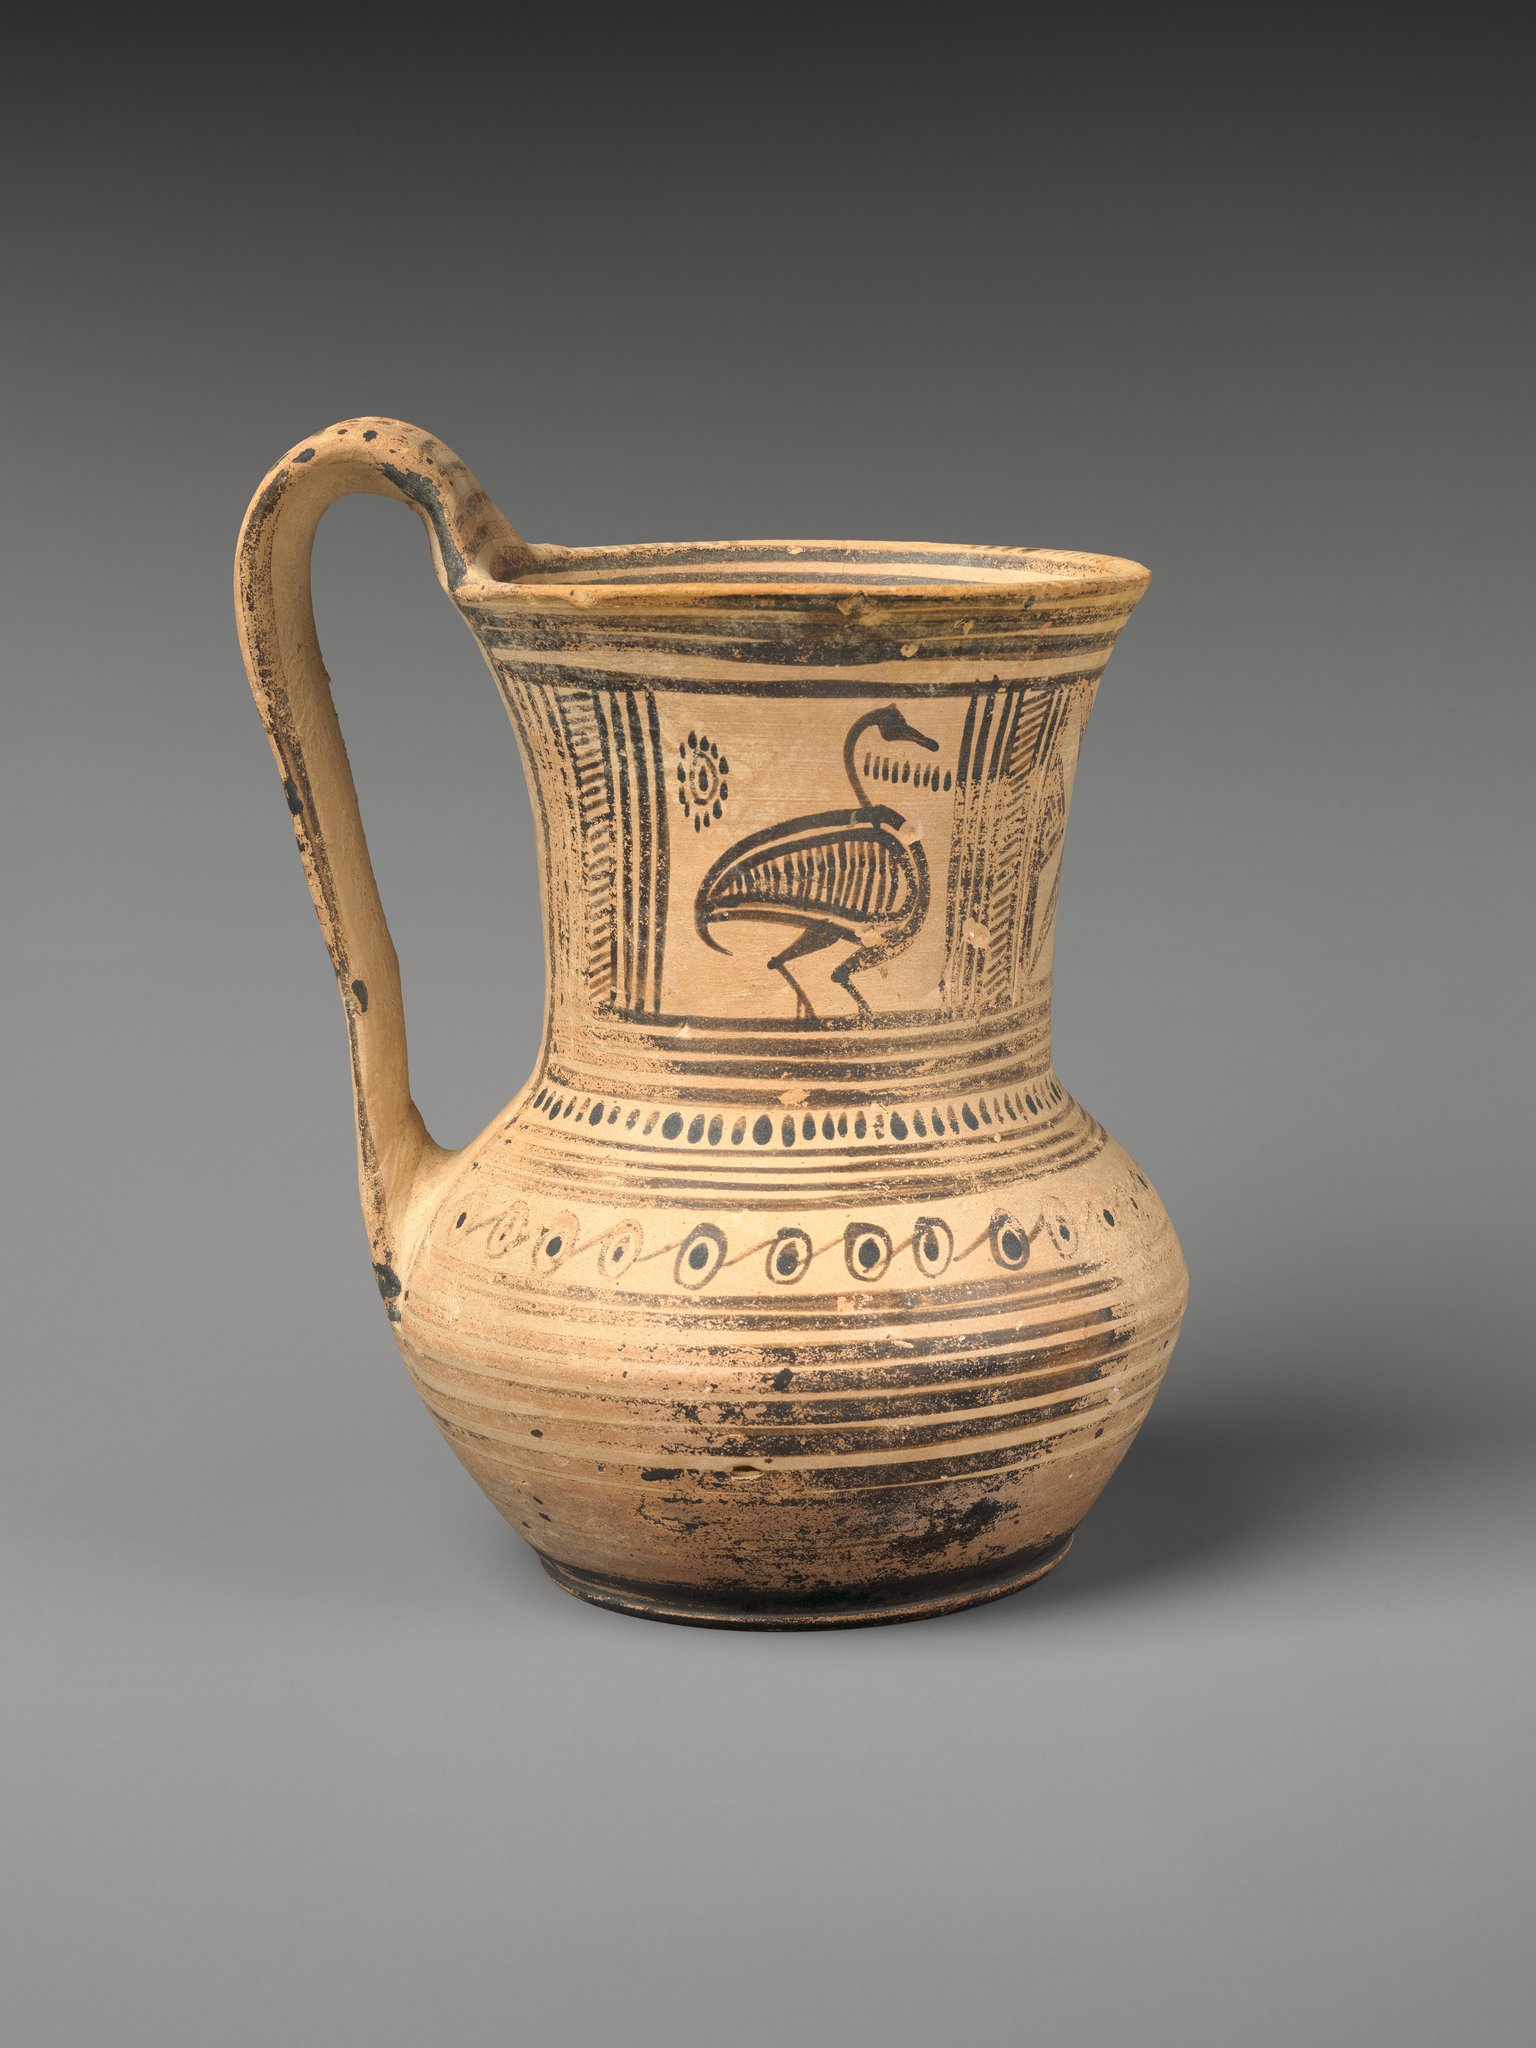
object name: jug, tankard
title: Terracotta tankard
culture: greek, attic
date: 750-725 BCE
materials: terracotta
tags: birds